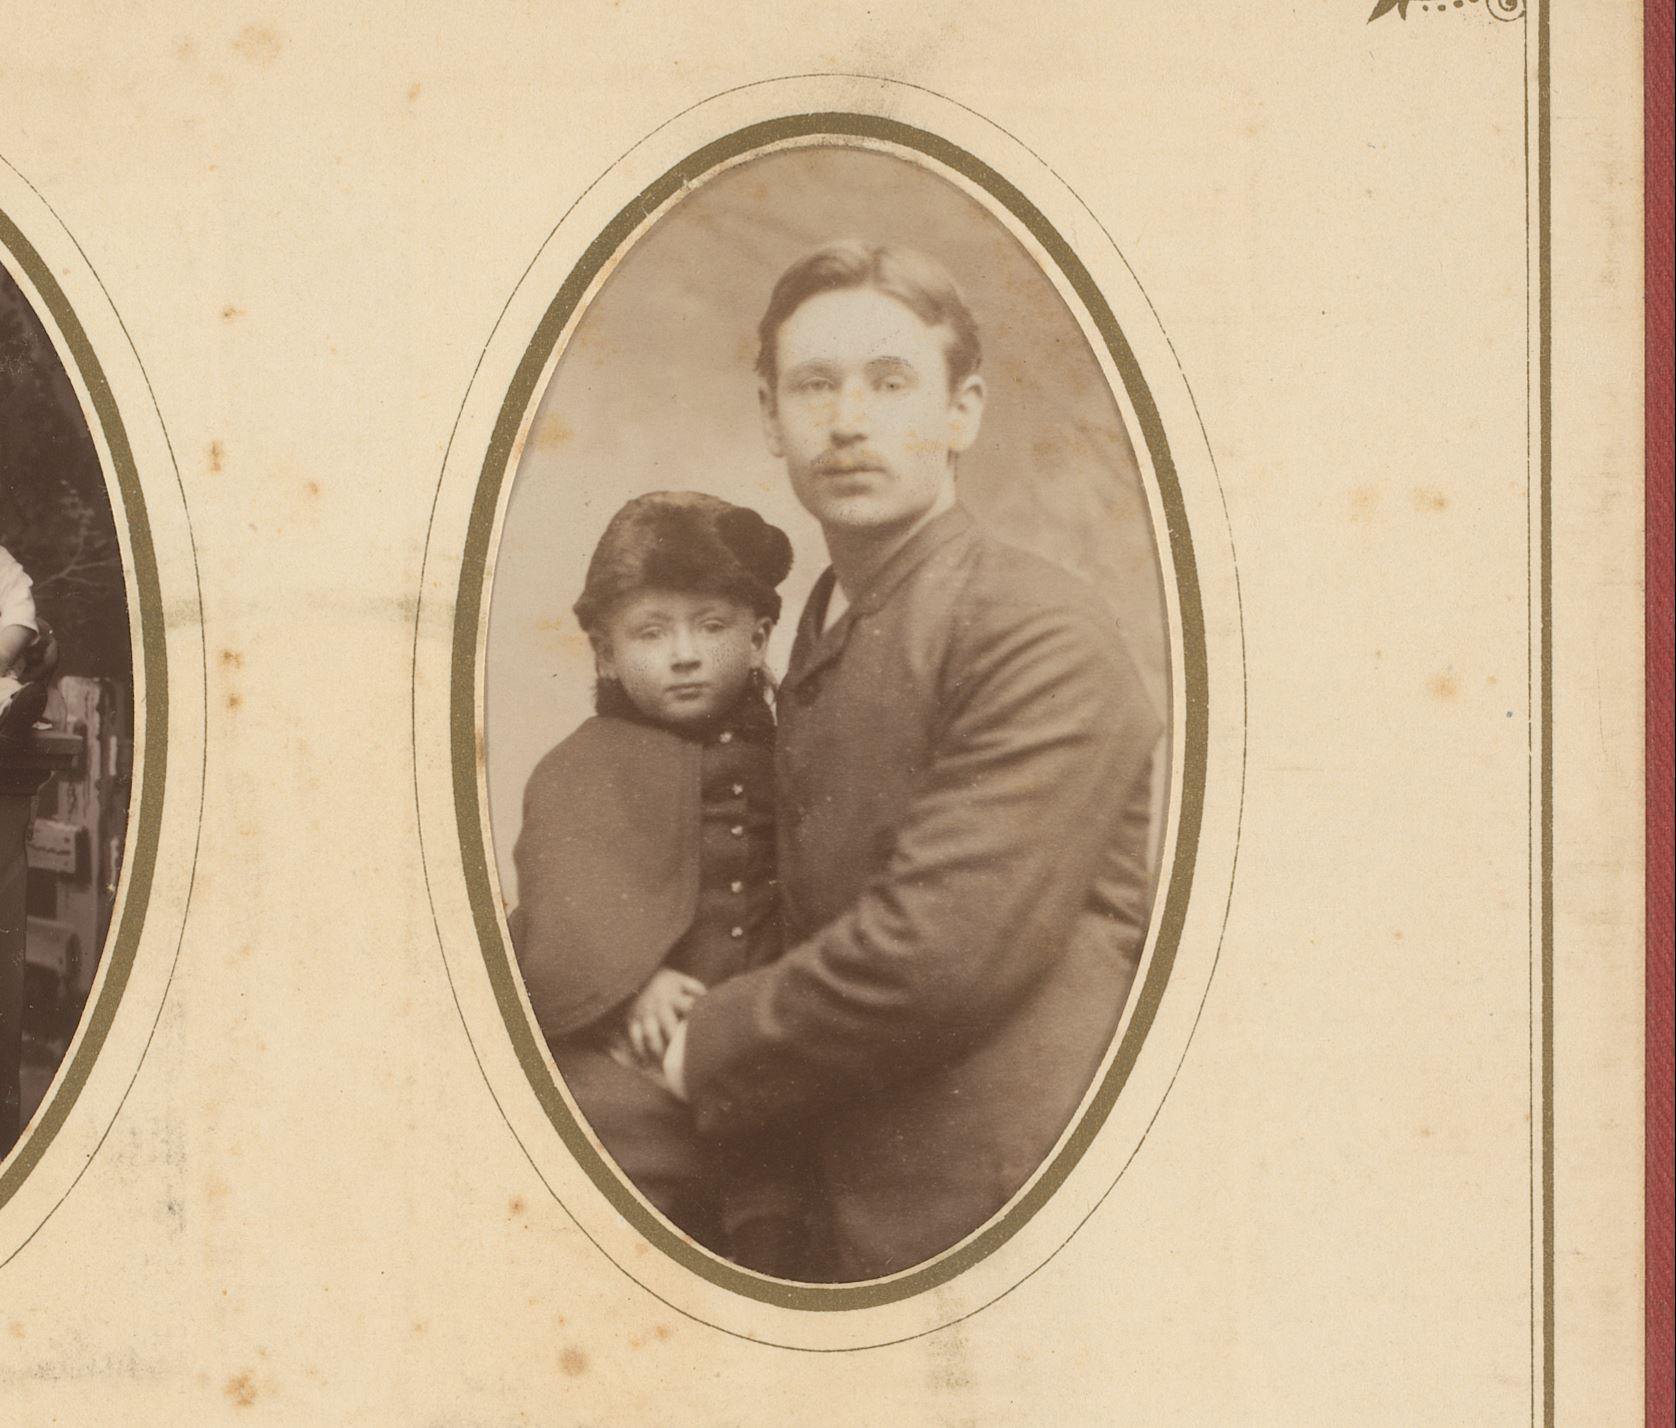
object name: album leaf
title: Portret van een man met een kind op de arm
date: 1885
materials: cardboard, photographic support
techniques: albumen print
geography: rotterdam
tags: historical persons, tot, toddler ~ the ages of man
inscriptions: inscription: ‘Photographie Parisienne/ Rotterdam/ 123, Rue Van Oldenbarnevelt, 123./ ATELIER SPÉCIAL’